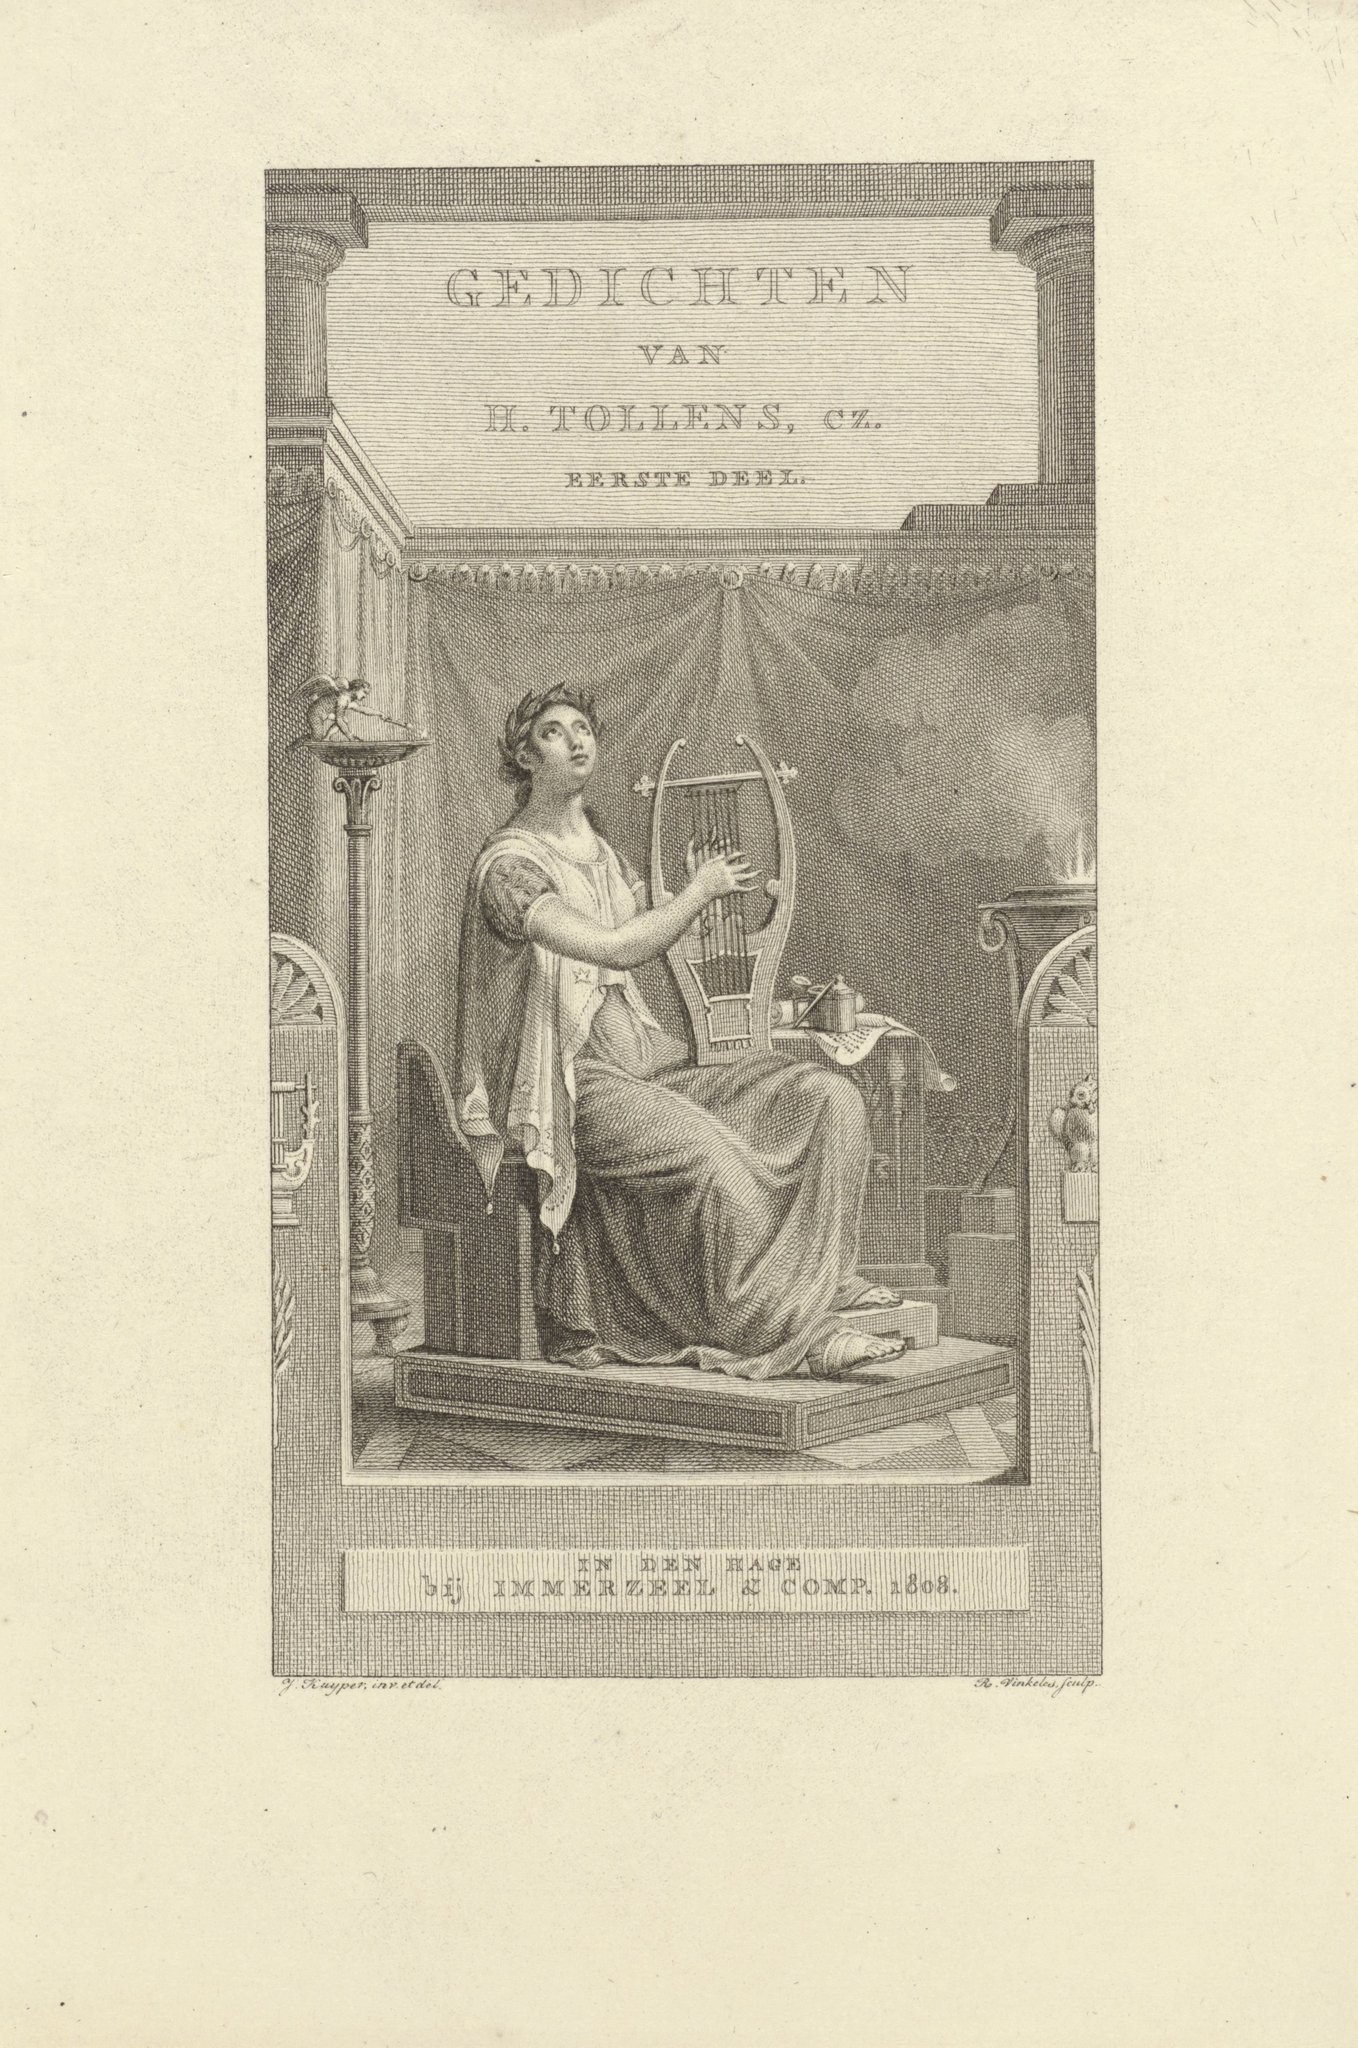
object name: titelblad, titelpagina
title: Titelpagina voor "Gedichten van H. Tollens Cz., deel 1', 1808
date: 1808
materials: paper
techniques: engraving, etching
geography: amsterdam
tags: harp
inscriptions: collector's mark: Lugt 2228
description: Titelpagina voor: Tollens Cz, Henricus Franciscus. Gedichten van H. Tollens Cz., eerste deel. Den Haag: Immerzeel en comp., 1808.